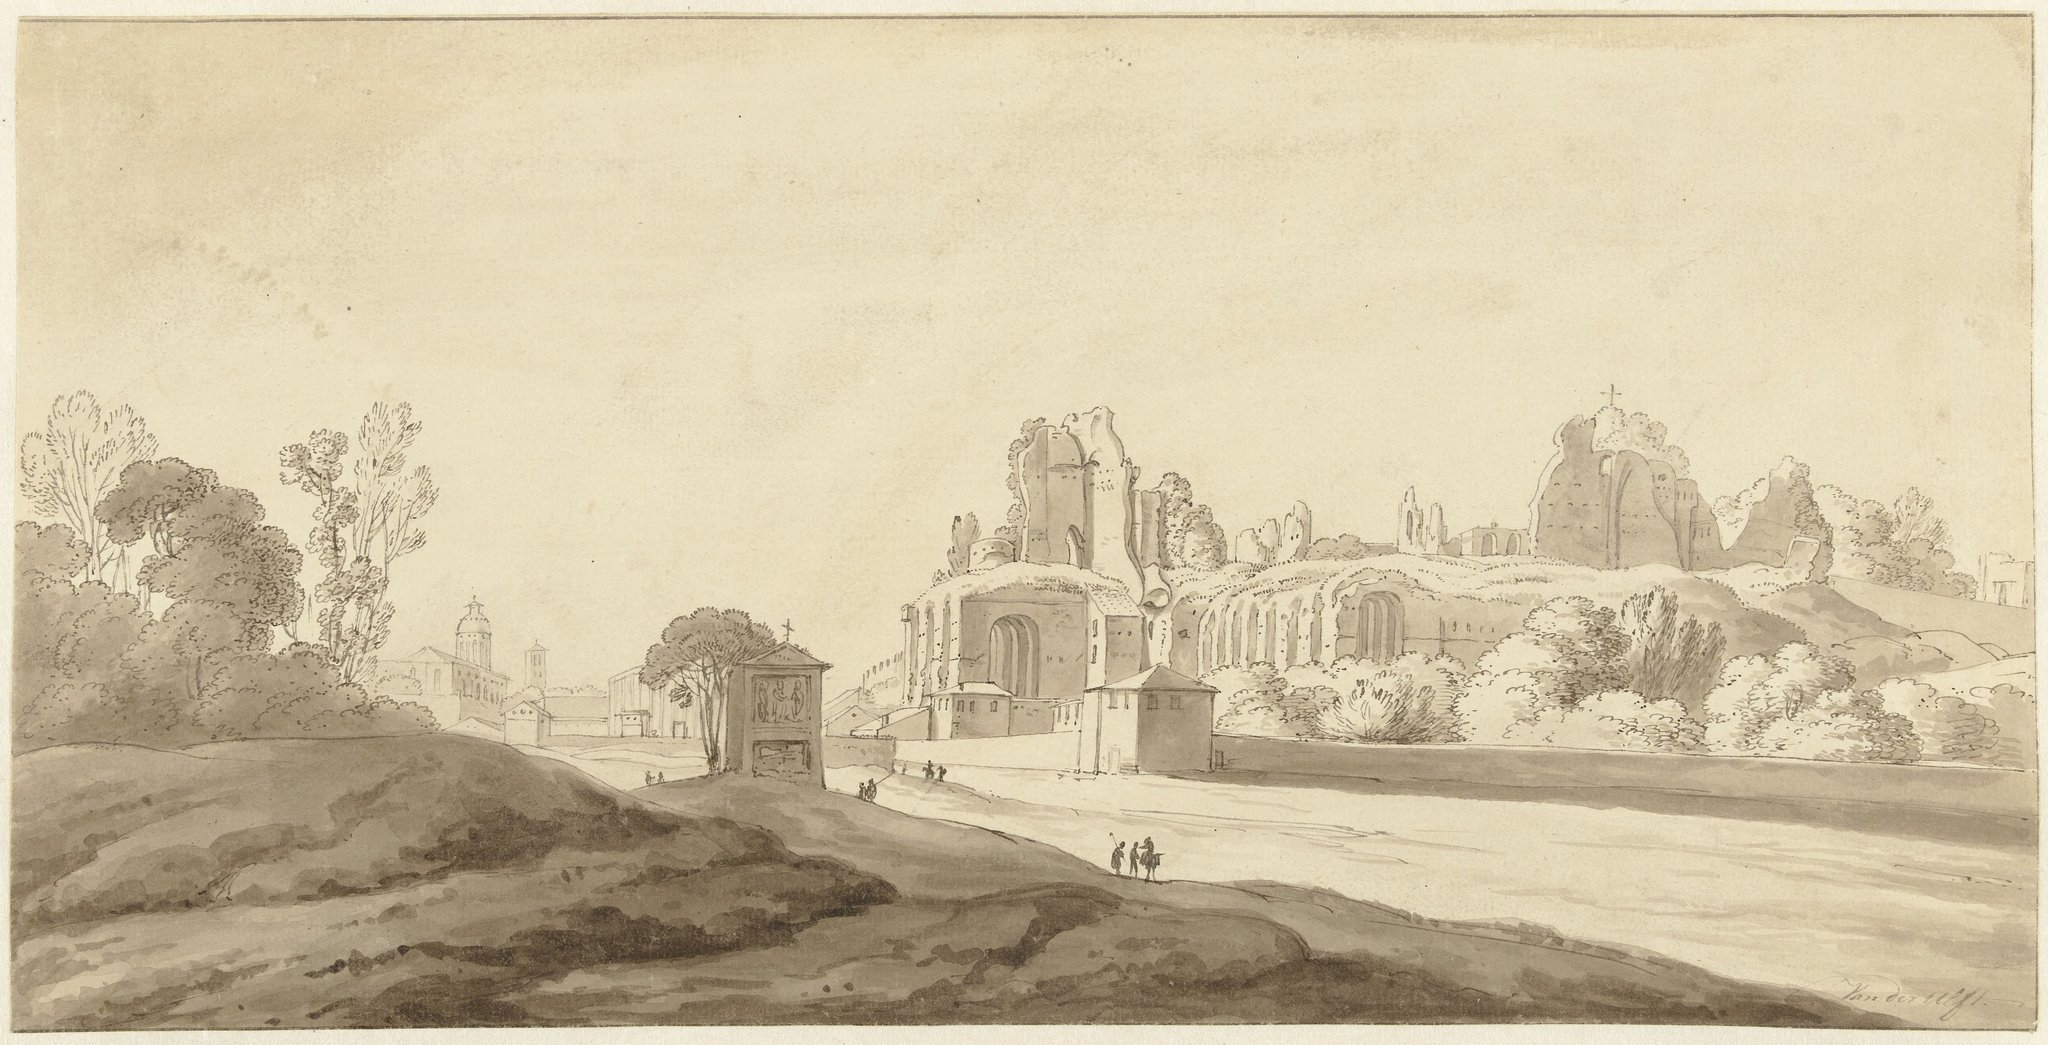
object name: drawing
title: Gezicht op de ruïnes van het paleis op de Palatijn te Rome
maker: jean grandjean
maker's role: draughtsman, print maker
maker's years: 1752-1781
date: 1765-1781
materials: ink, paper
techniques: brush, pen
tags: ruin of a building ~ architecture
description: Gezicht op de ruïnes van het paleis op de Palatijn te Rome. Het paleis is gezien vanuit het zuid-oosten.